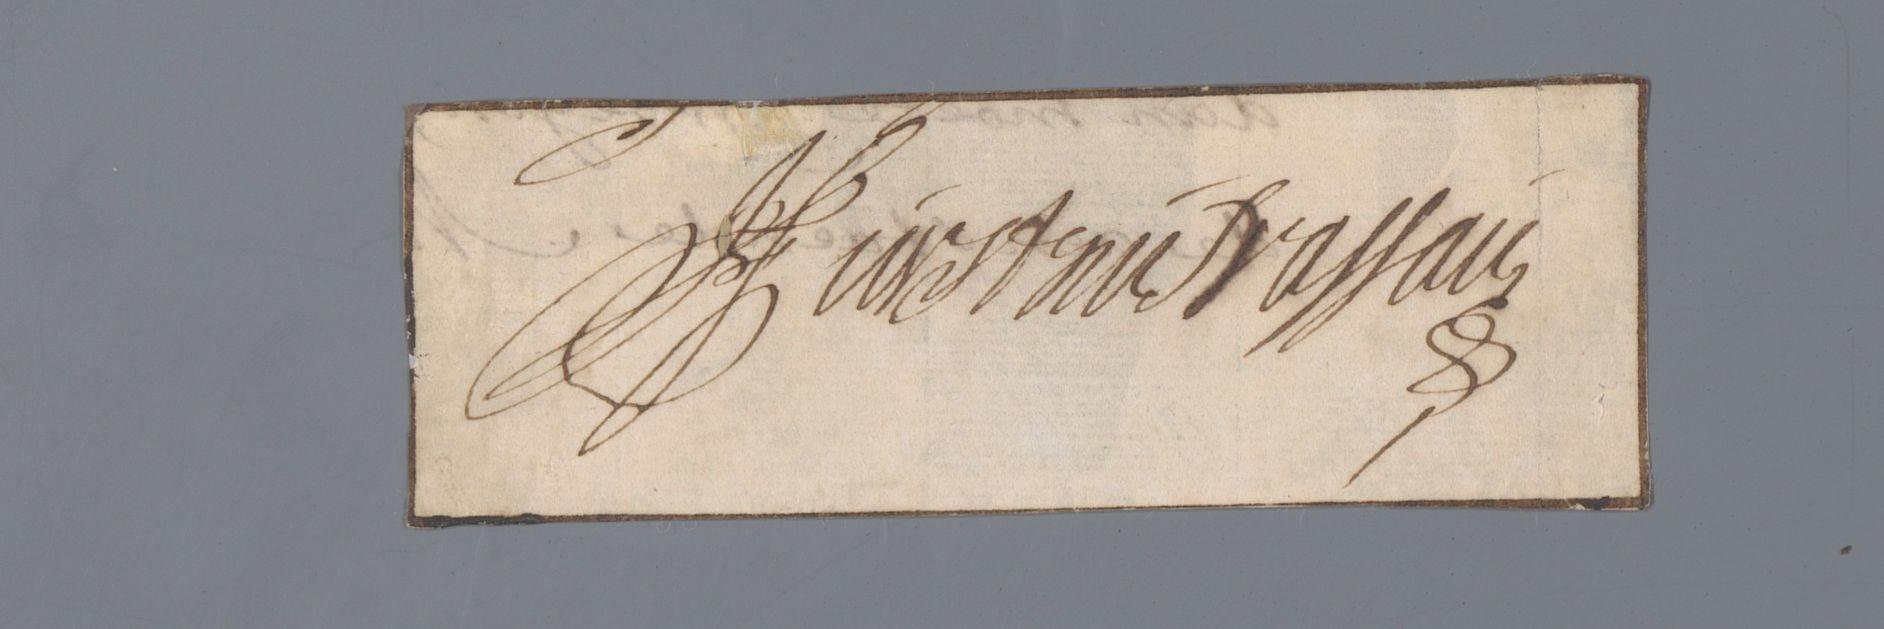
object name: document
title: Handtekening van Hendrik Casimir II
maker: hendrik casimir ii graaf van nassau-dietz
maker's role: stadhouder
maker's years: 1657-1696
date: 1650-1700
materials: ink, paper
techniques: writing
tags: the hague, hendrik casimir ii graaf van nassau-dietz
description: Handtekening in bruine inkt (van Hendrik Casimir II) op uitgeknipt blaadje papier. Gesigneerd: Fùrst zu Nassau.